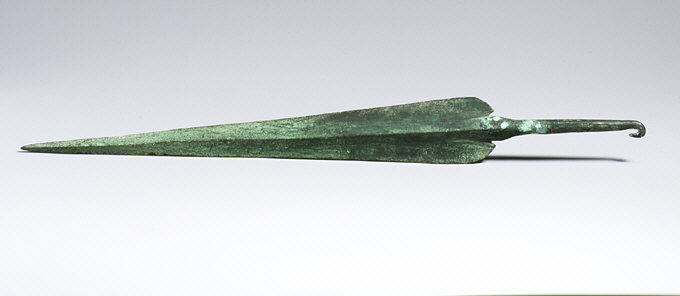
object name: dagger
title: Copper alloy spearhead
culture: cypriot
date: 2500-2000 BCE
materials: bronze